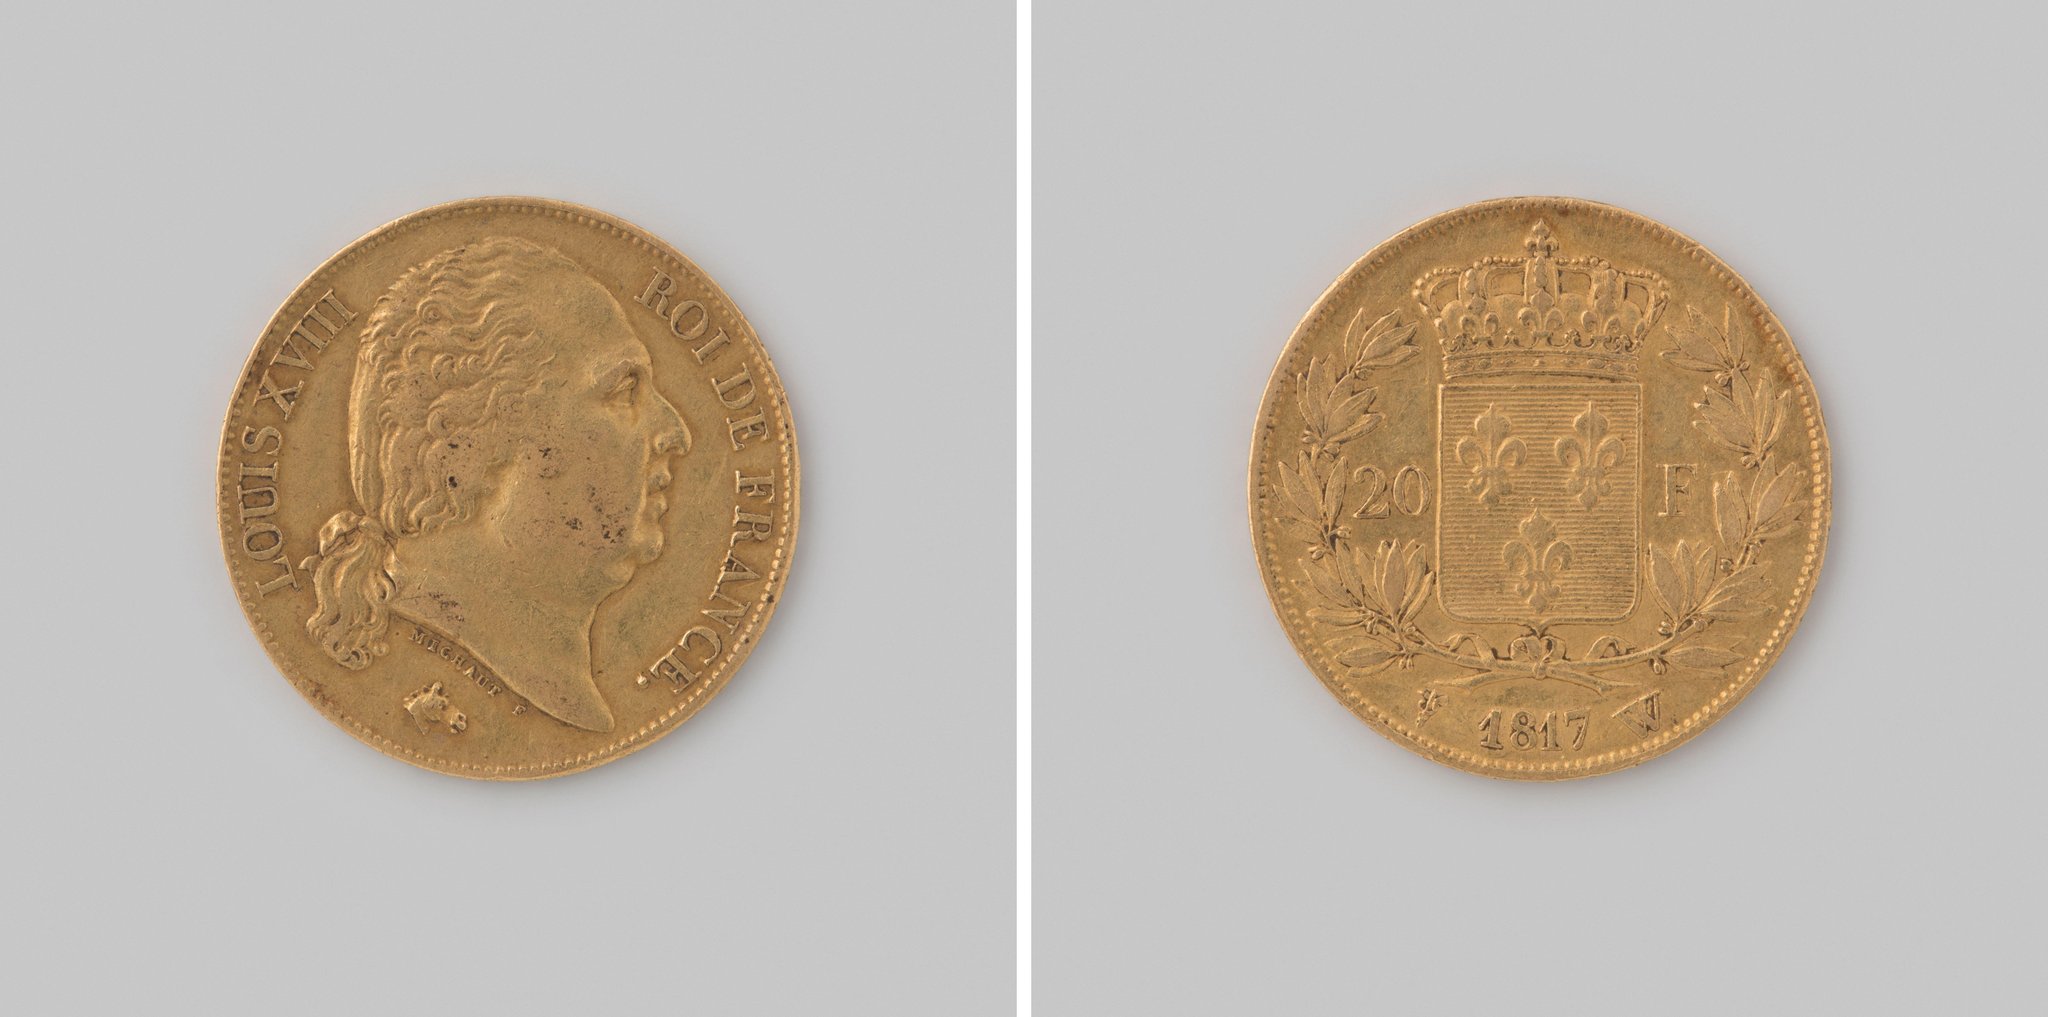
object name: coin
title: Koninkrijk Frankrijk, Lodewijk XVIII, 20 francs, 1817 VV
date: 1817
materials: gold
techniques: striking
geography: lille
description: Gouden munt. Voorzijde: hoofd van de koning naar rechts. Keerzijde: binnen twee samengebonden lauriertakken tussen waarde-aanduiding gekroond wapenschild. Onderaan jaartal. Rechts daarvan letters VV [=Lille]. Randschrift.